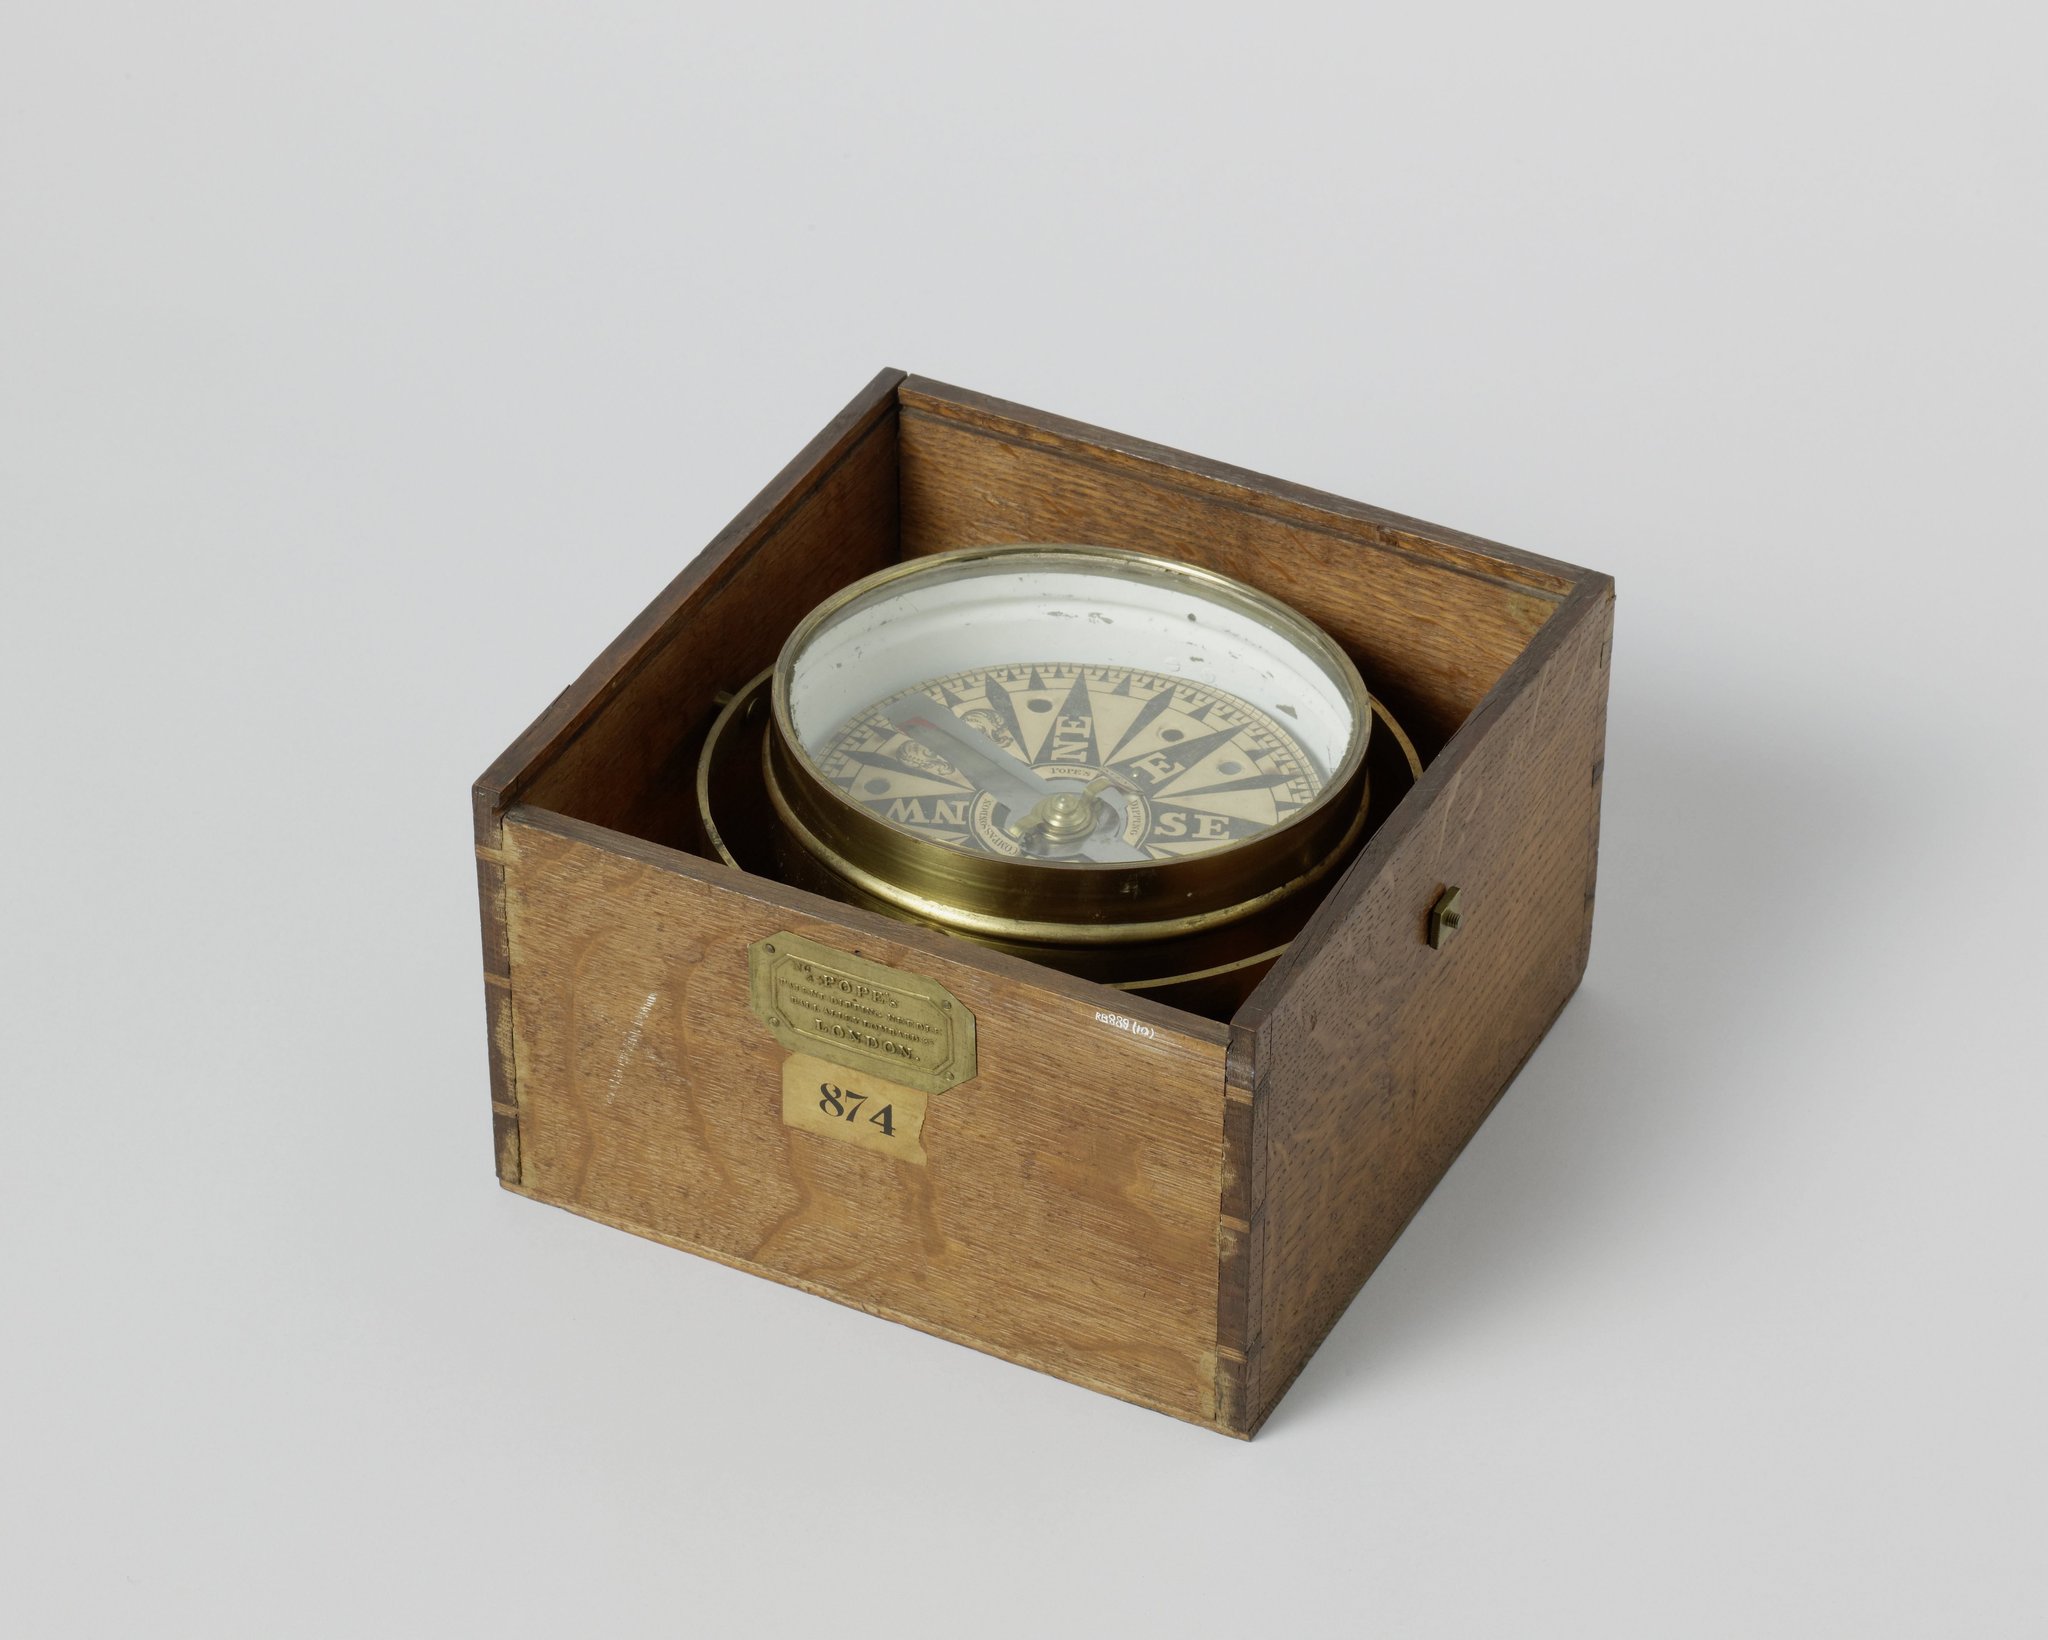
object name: compass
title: Dipping Needle Compass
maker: william pope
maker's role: instrument maker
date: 1820-1826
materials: brass, glass, iron, lead, paper, gemstone, wood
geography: london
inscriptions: inscription, on the compass card, verso: ‘N 516. Pope’s Patent Dipping Needle, 11 BALL ALLEY LOMBARD STREET, LONDON’, inscription, on the compass card, recto: ‘POPE’s PATENT DIPPING NEEDLE COMPASS LONDON’, inscription, on the lid of the compass box: ‘Gedeponeert / Z.K. [...] 1826 [...] / Nº 44’, inscription, on the compass box: ‘Nº4 POPE’s / PATENT DIPPING NEEDLE / BALL ALLEY LOMBARD ST / LONDON.’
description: Inclinatiekompas in cardanusring in een houten doos. De kompasketel is verzwaard met een loden gewicht onderin. De roos heeft een gat in het midden, waarover een messing brug loopt met het ophangpunt voor de pen; het gat in de roos laat ruimte om de naald, die met een as aan de brug is bevestigd, verticaal te laten hellen onafhankelijk van de roos. Met dun lood onderop is de roos uitgebalanceerd.